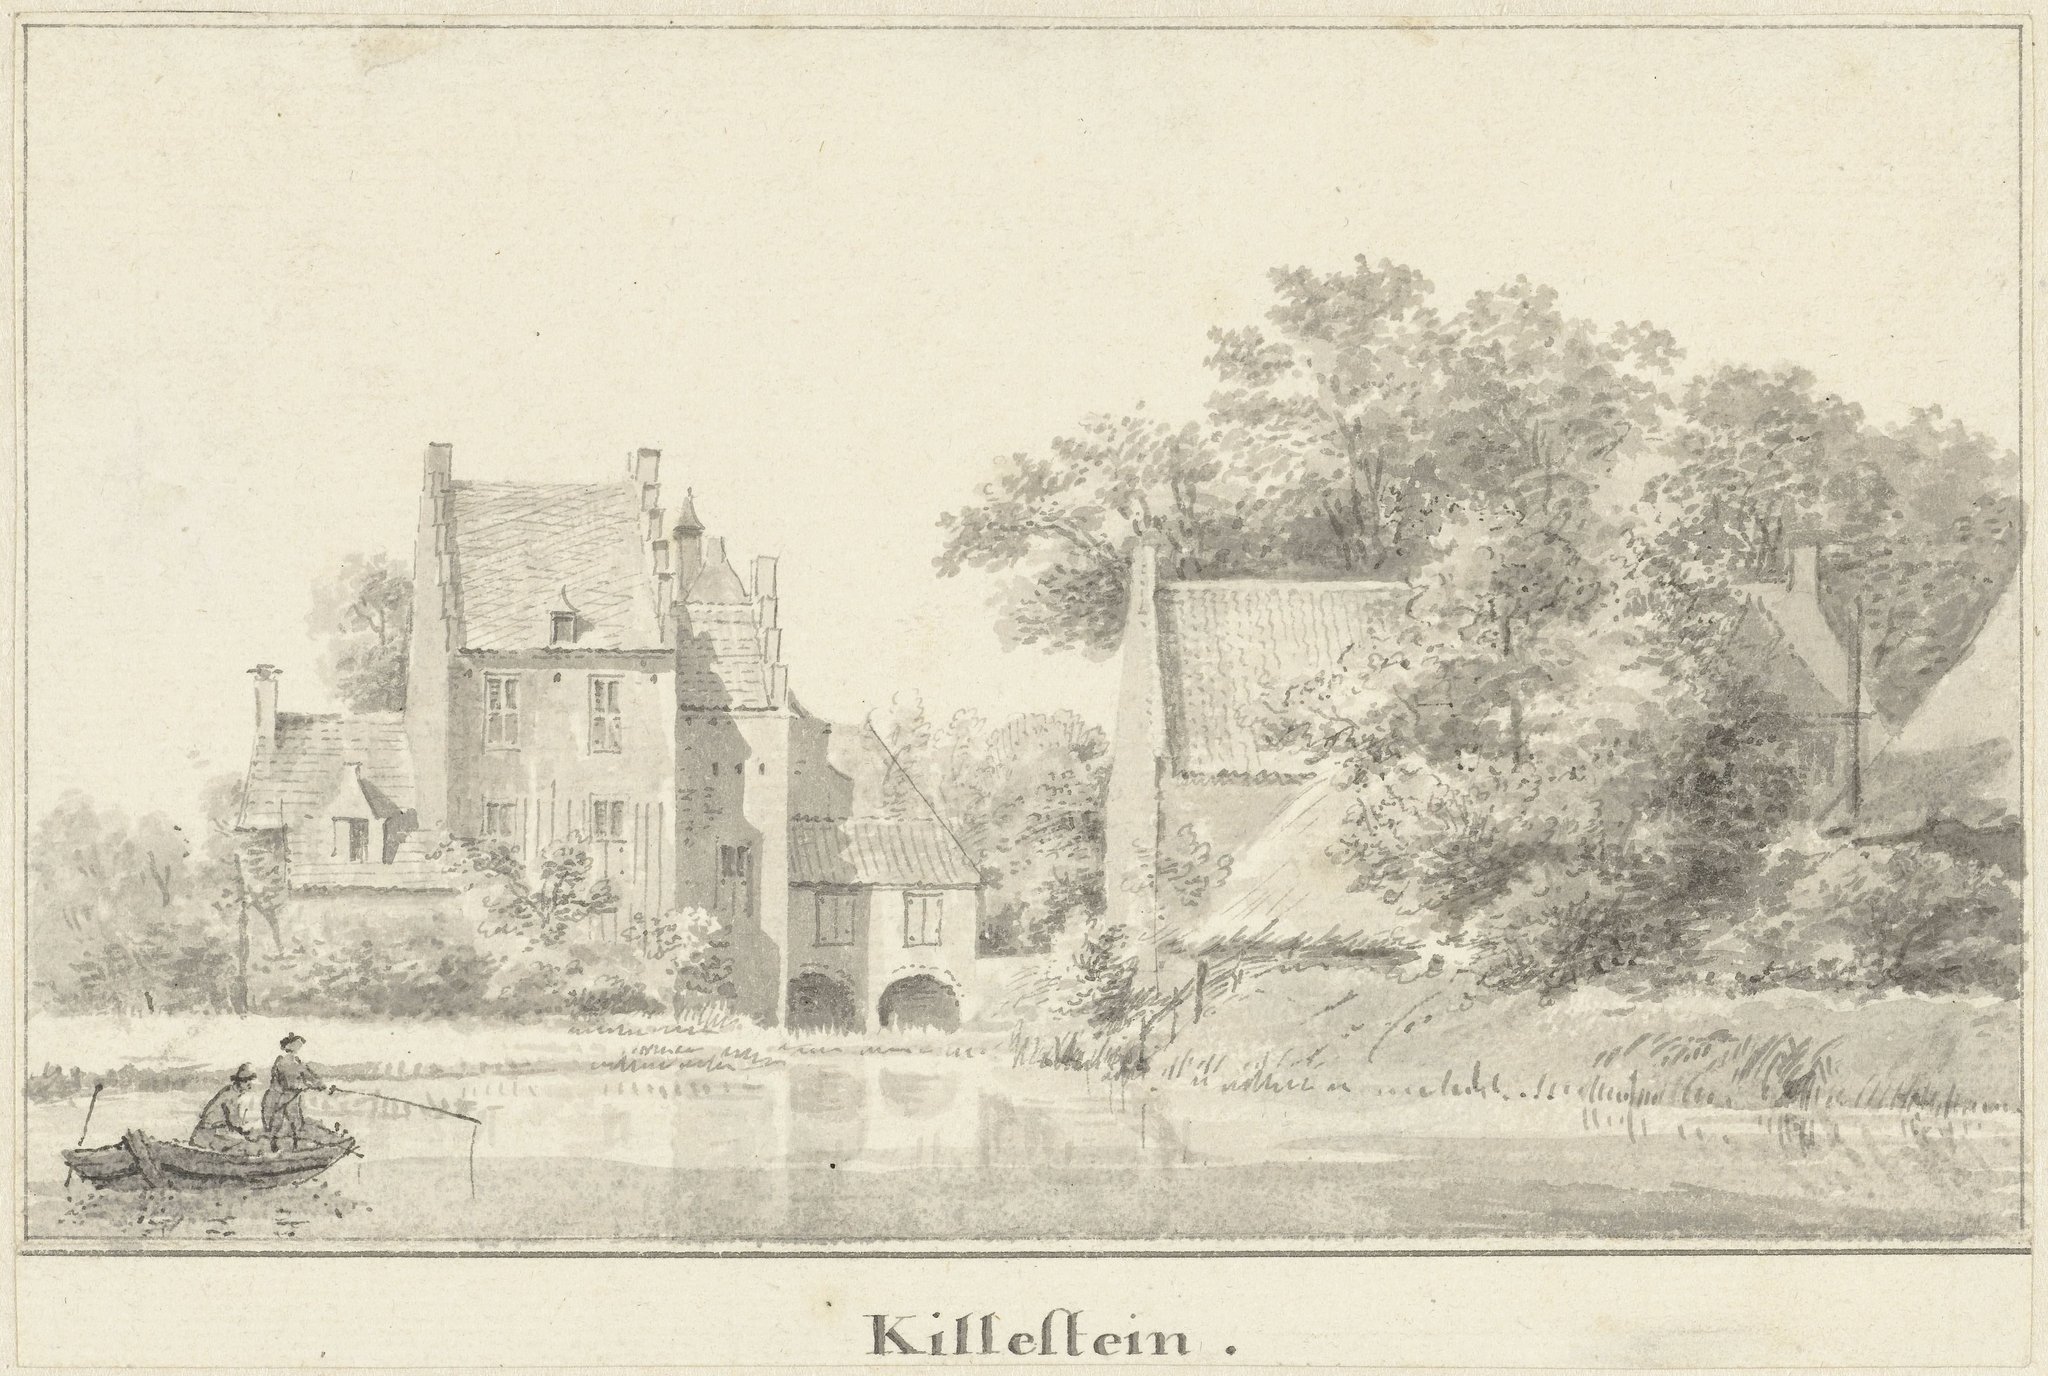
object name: drawing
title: Het Huis Killenstein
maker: abraham de haen (ii)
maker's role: draughtsman, print maker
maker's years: 1707-1748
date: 1717-1748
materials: ink, paper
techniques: brush, pen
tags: castle